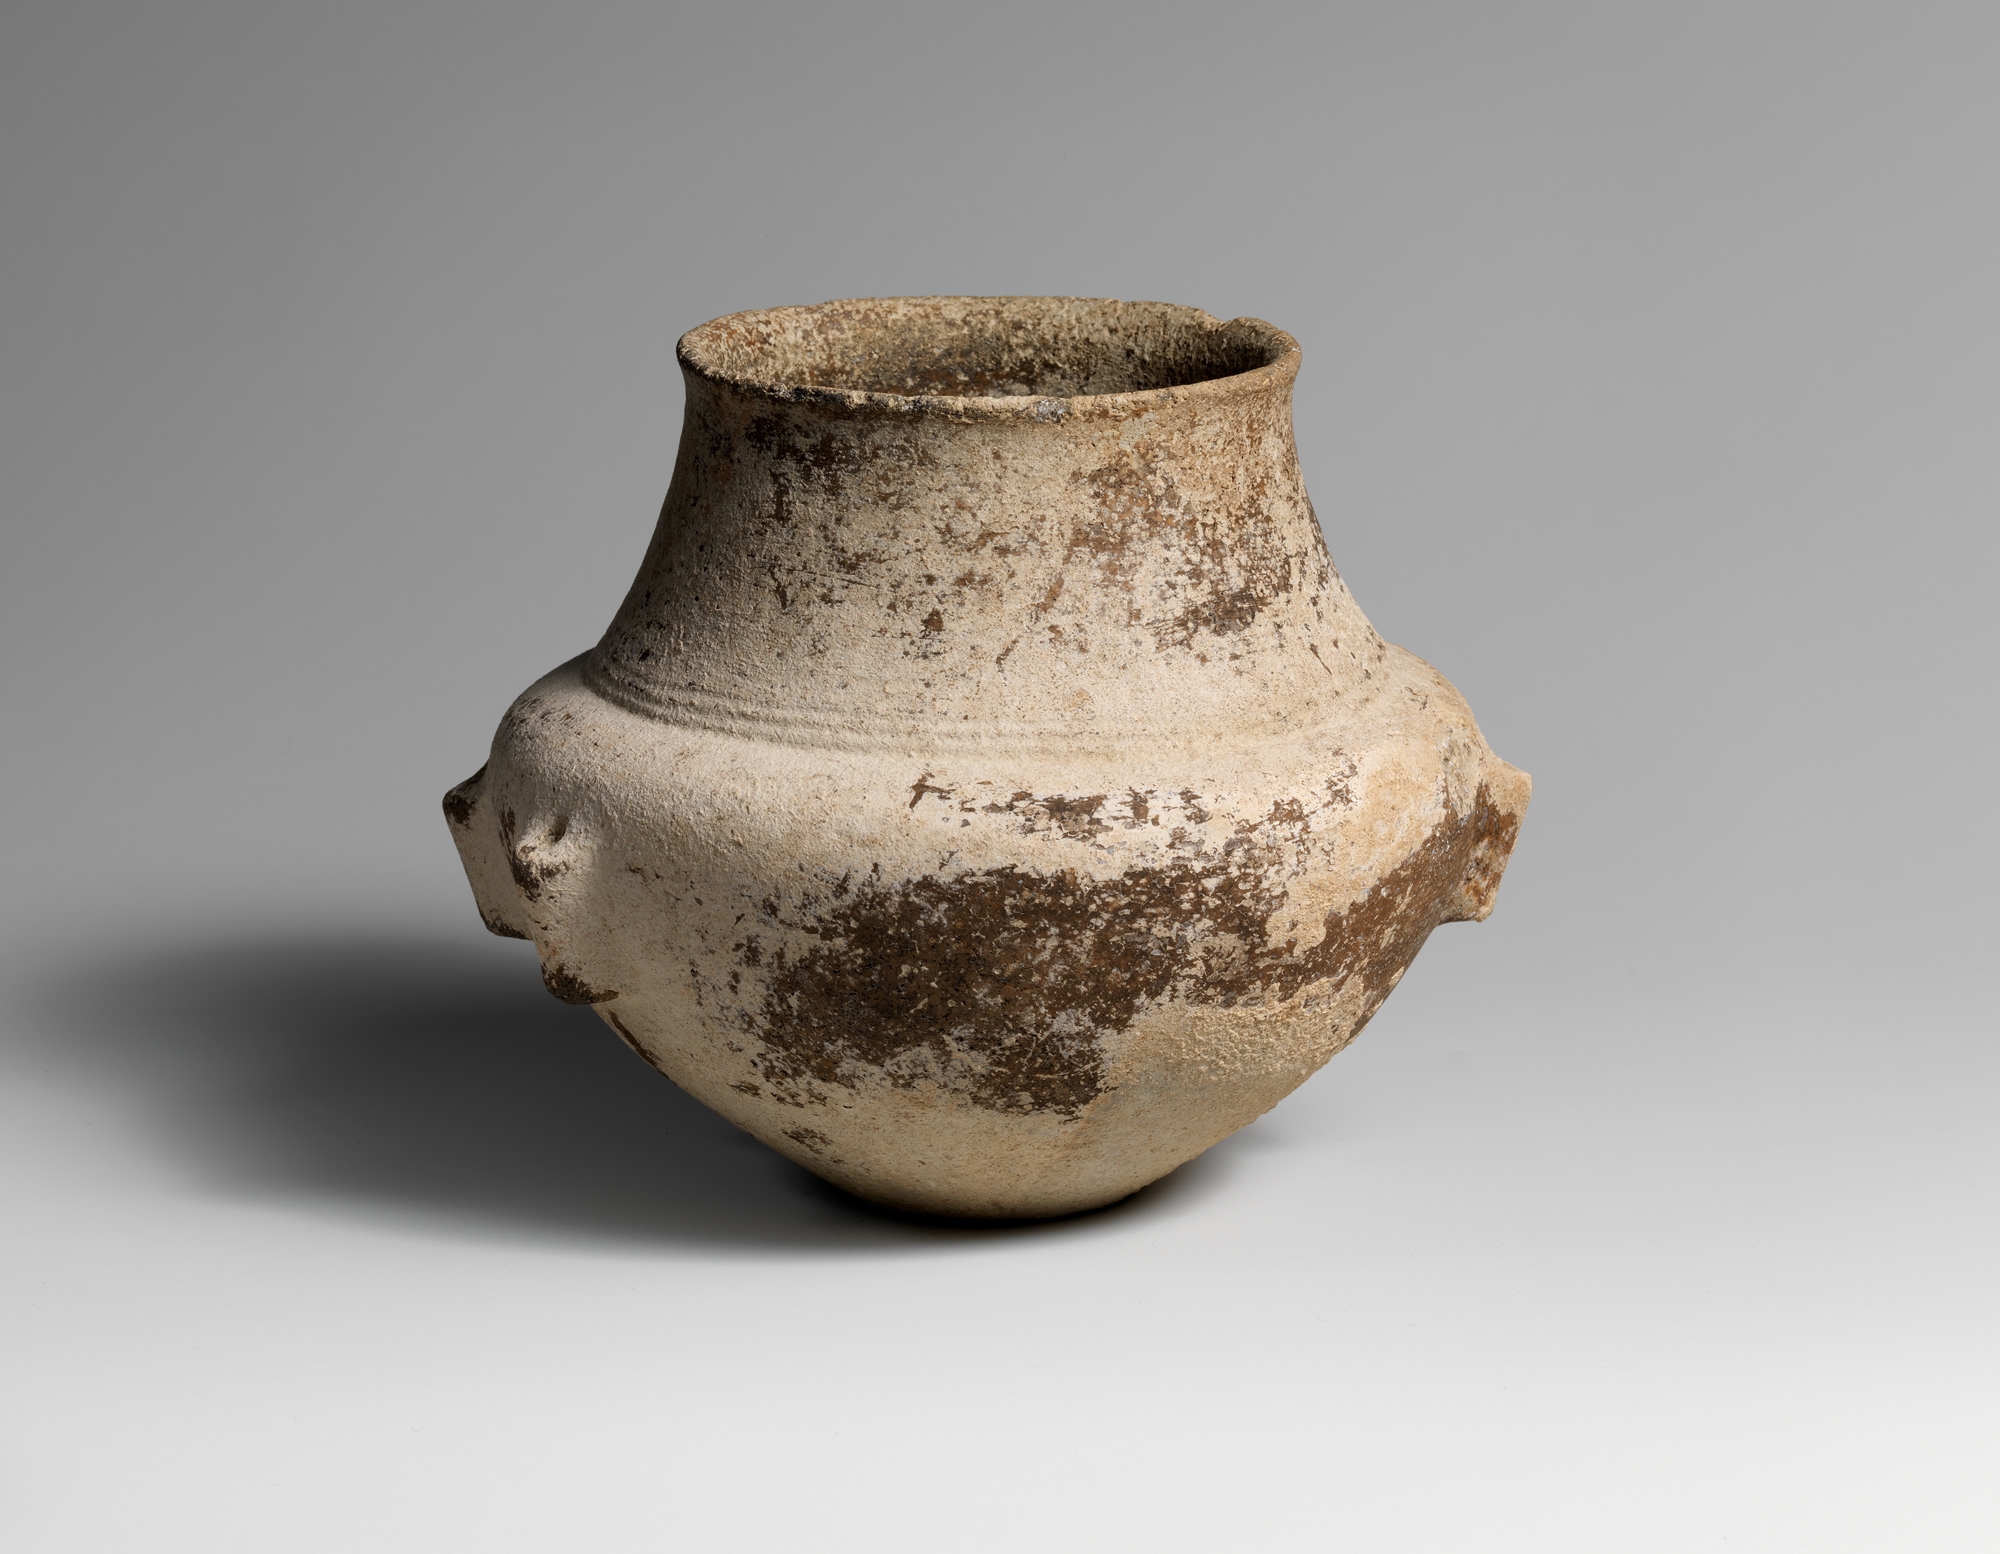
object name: collared jar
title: Terracotta collared jar with four lug handles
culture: cycladic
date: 2700 BCE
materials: terracotta